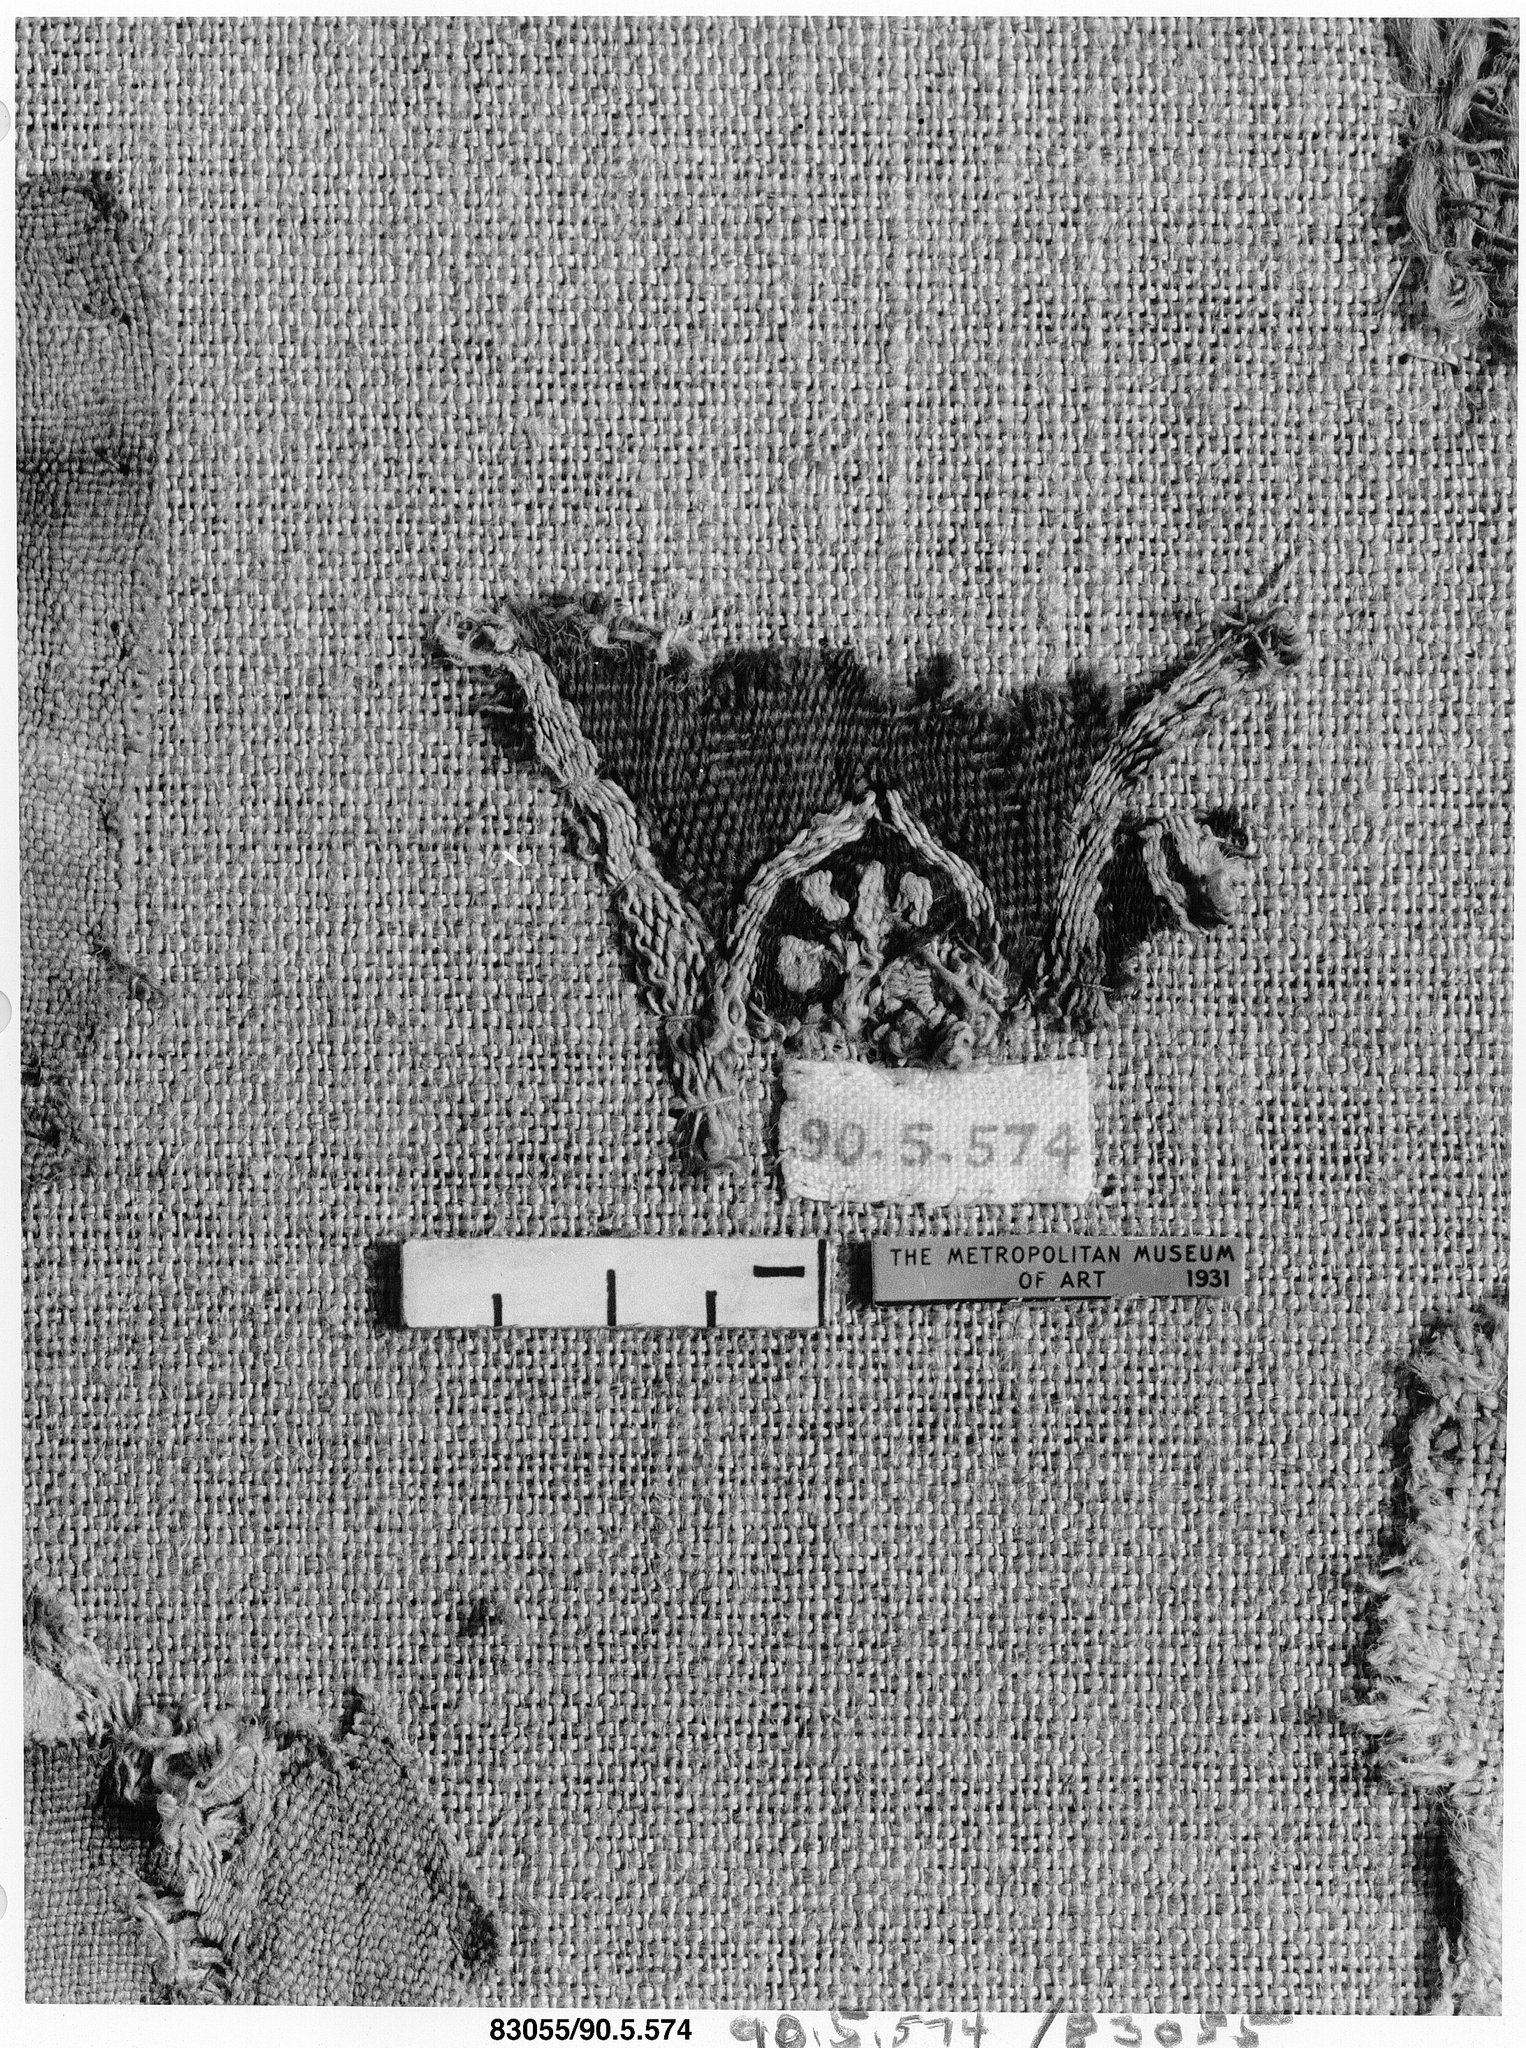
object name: textile fragment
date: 301-500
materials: linen, wool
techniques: weave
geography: egypt